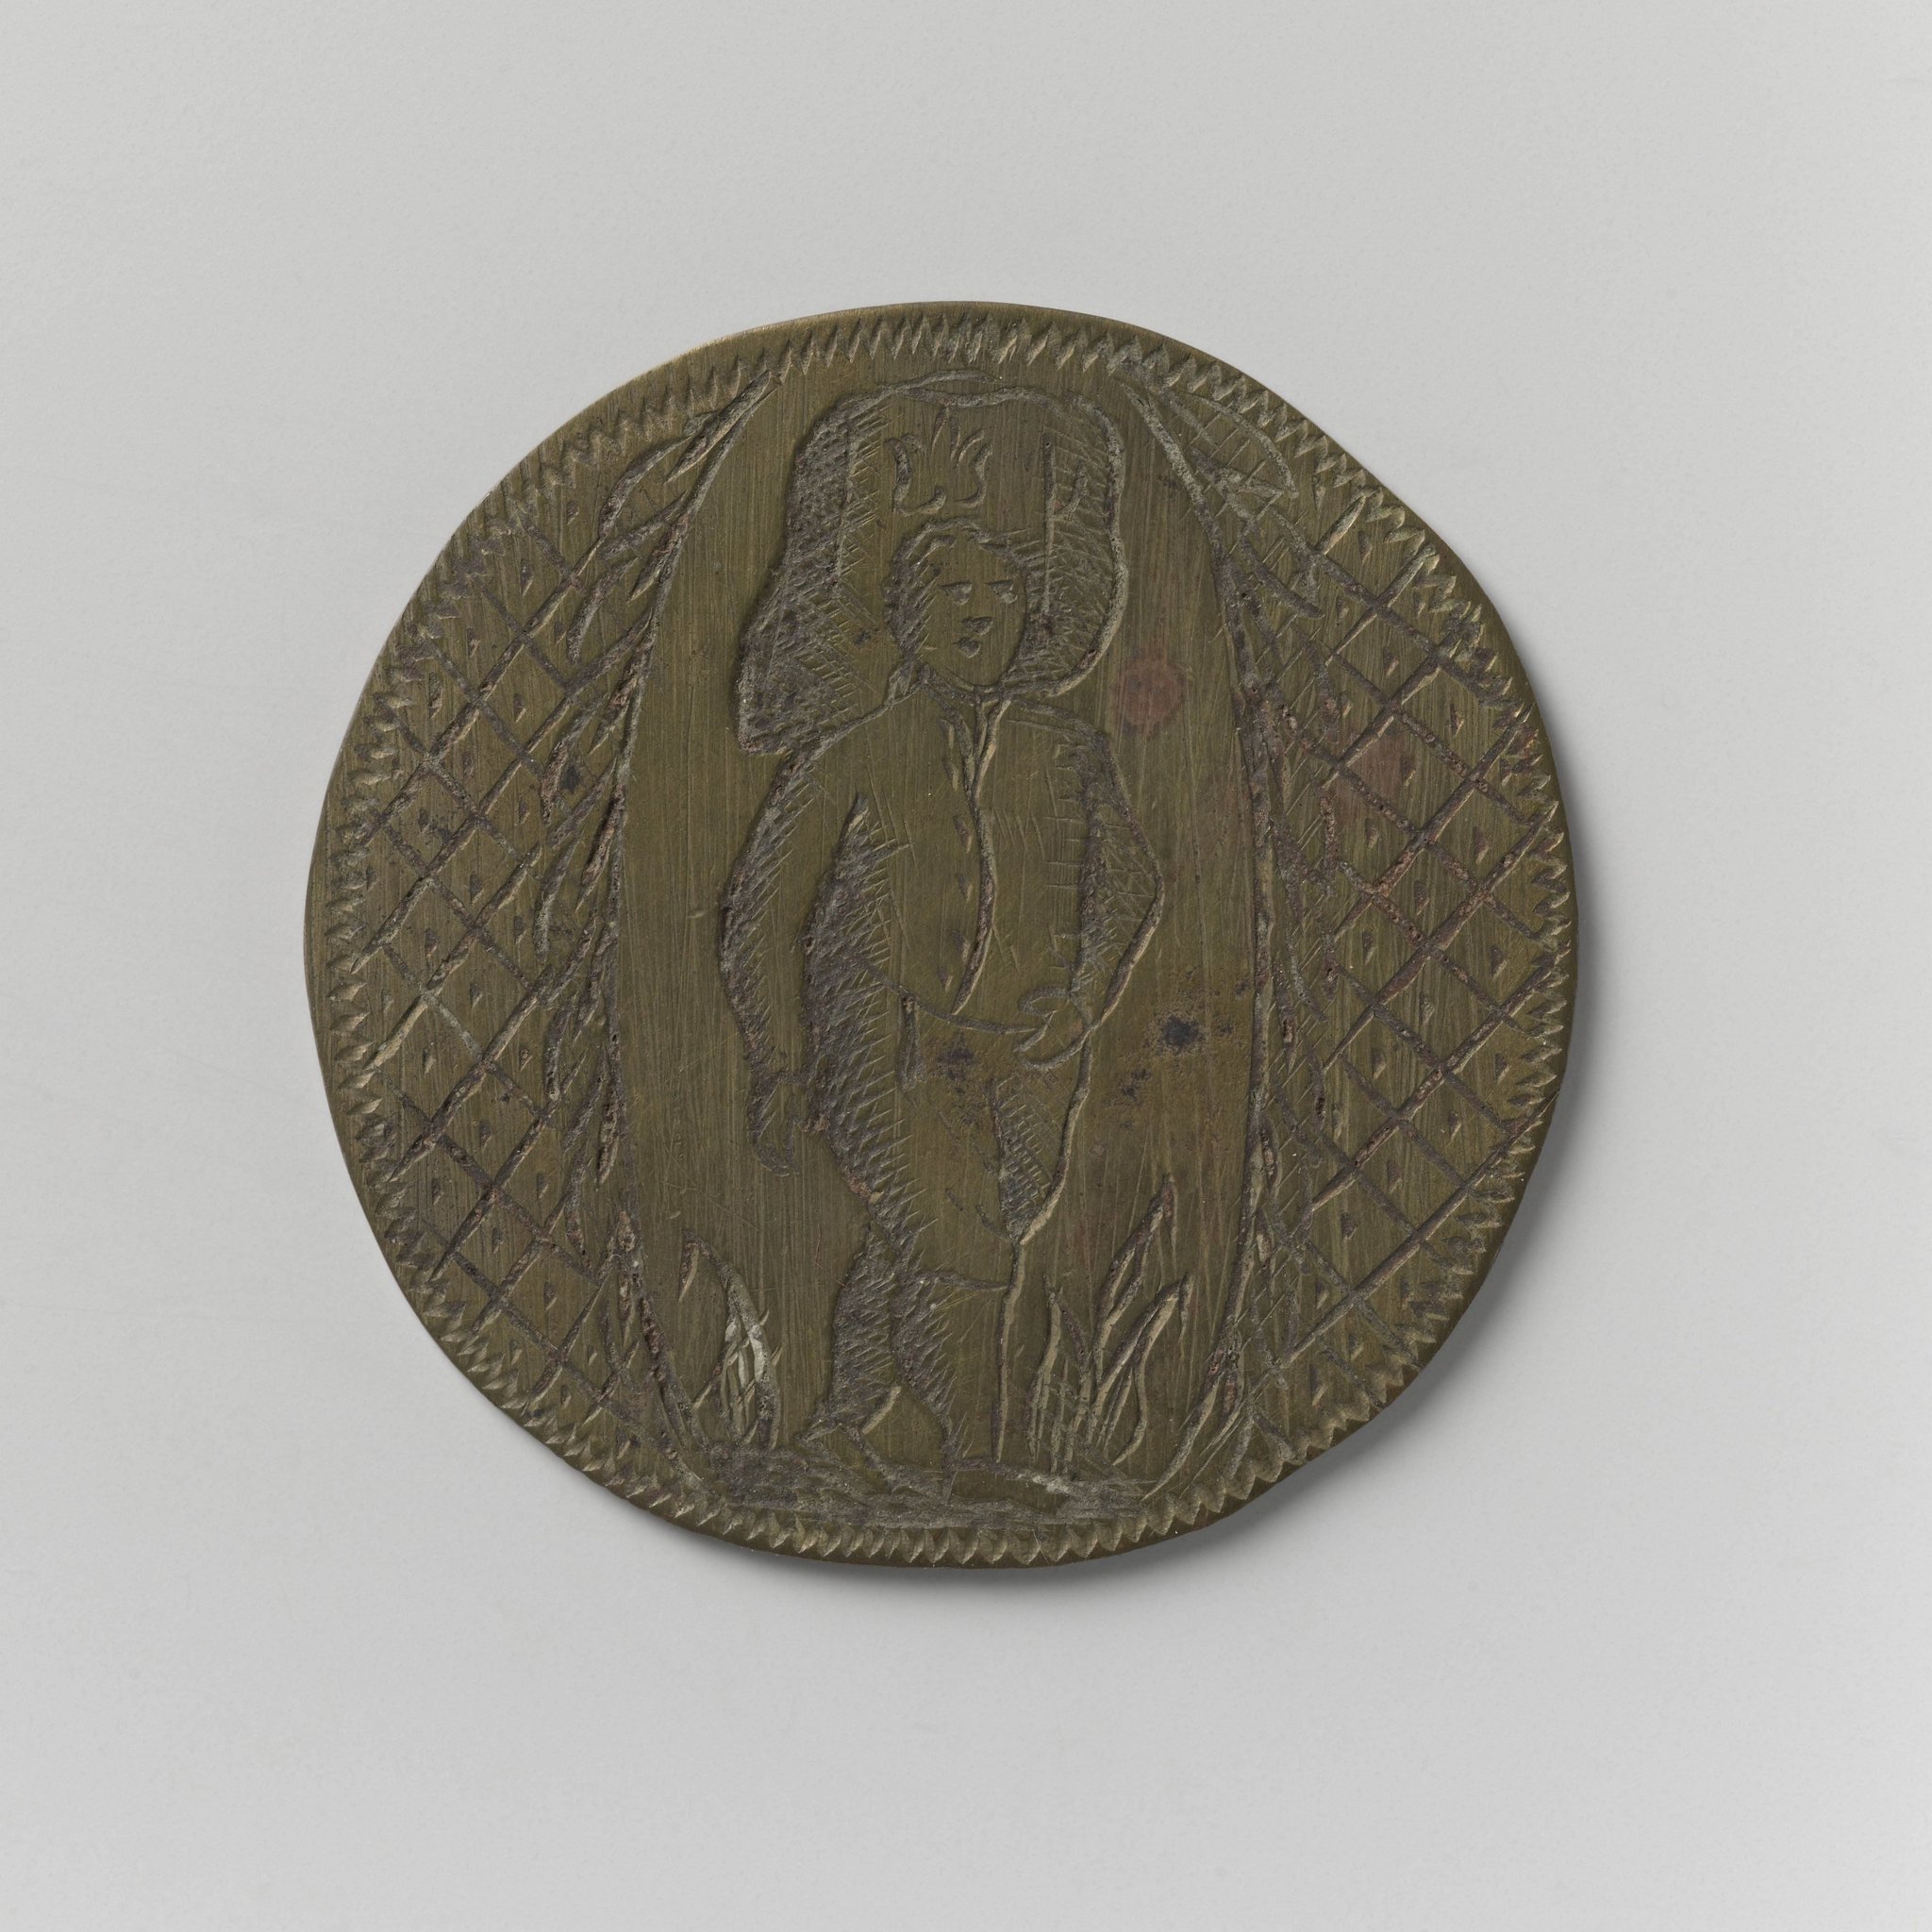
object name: medal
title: Korendragers- en -stortersgilde van Amsterdam, gildepenning van Jan Jacob de Leeuw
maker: Anonymous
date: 1792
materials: brass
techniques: engraving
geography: amsterdam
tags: amsterdam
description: Messing penning. Voorzijde: lichtelijk naar rechts gewende man met last op hoofd binnen bladerkrans; achtergrond: gearceerd. Keerzijde: opschrift